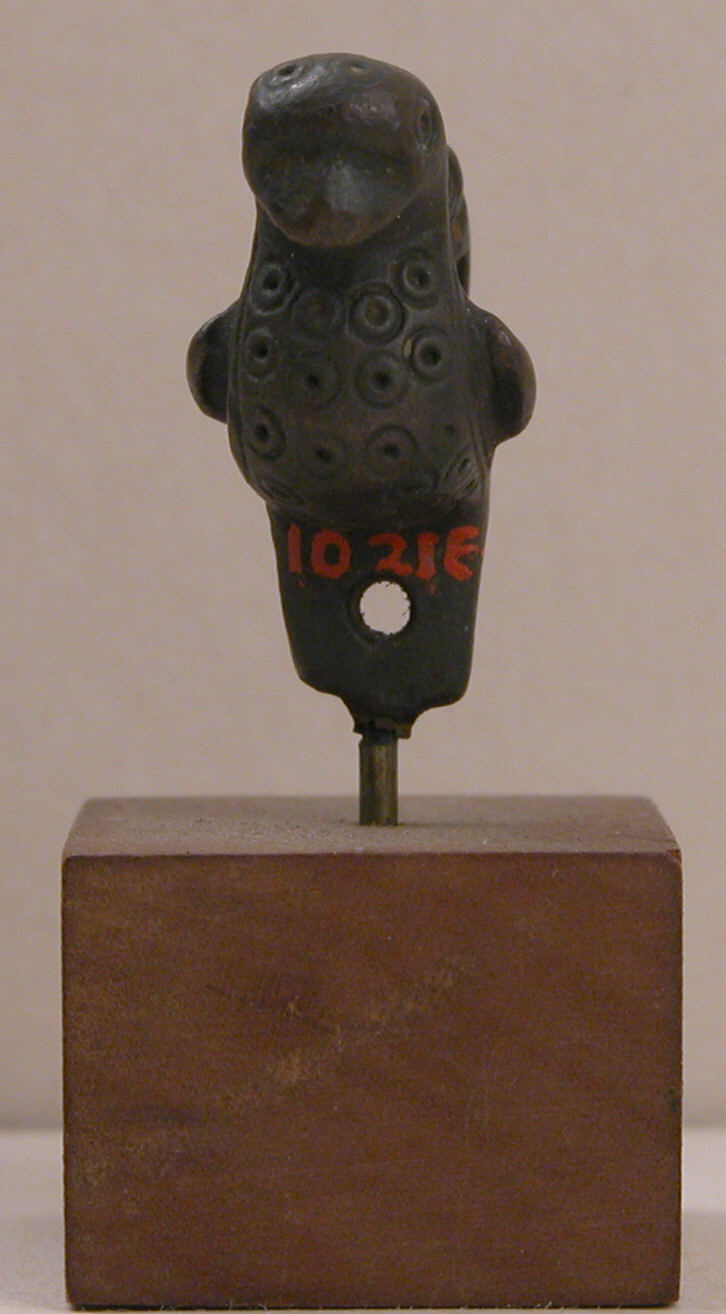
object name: figure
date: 1201-1400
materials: bronze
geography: iran